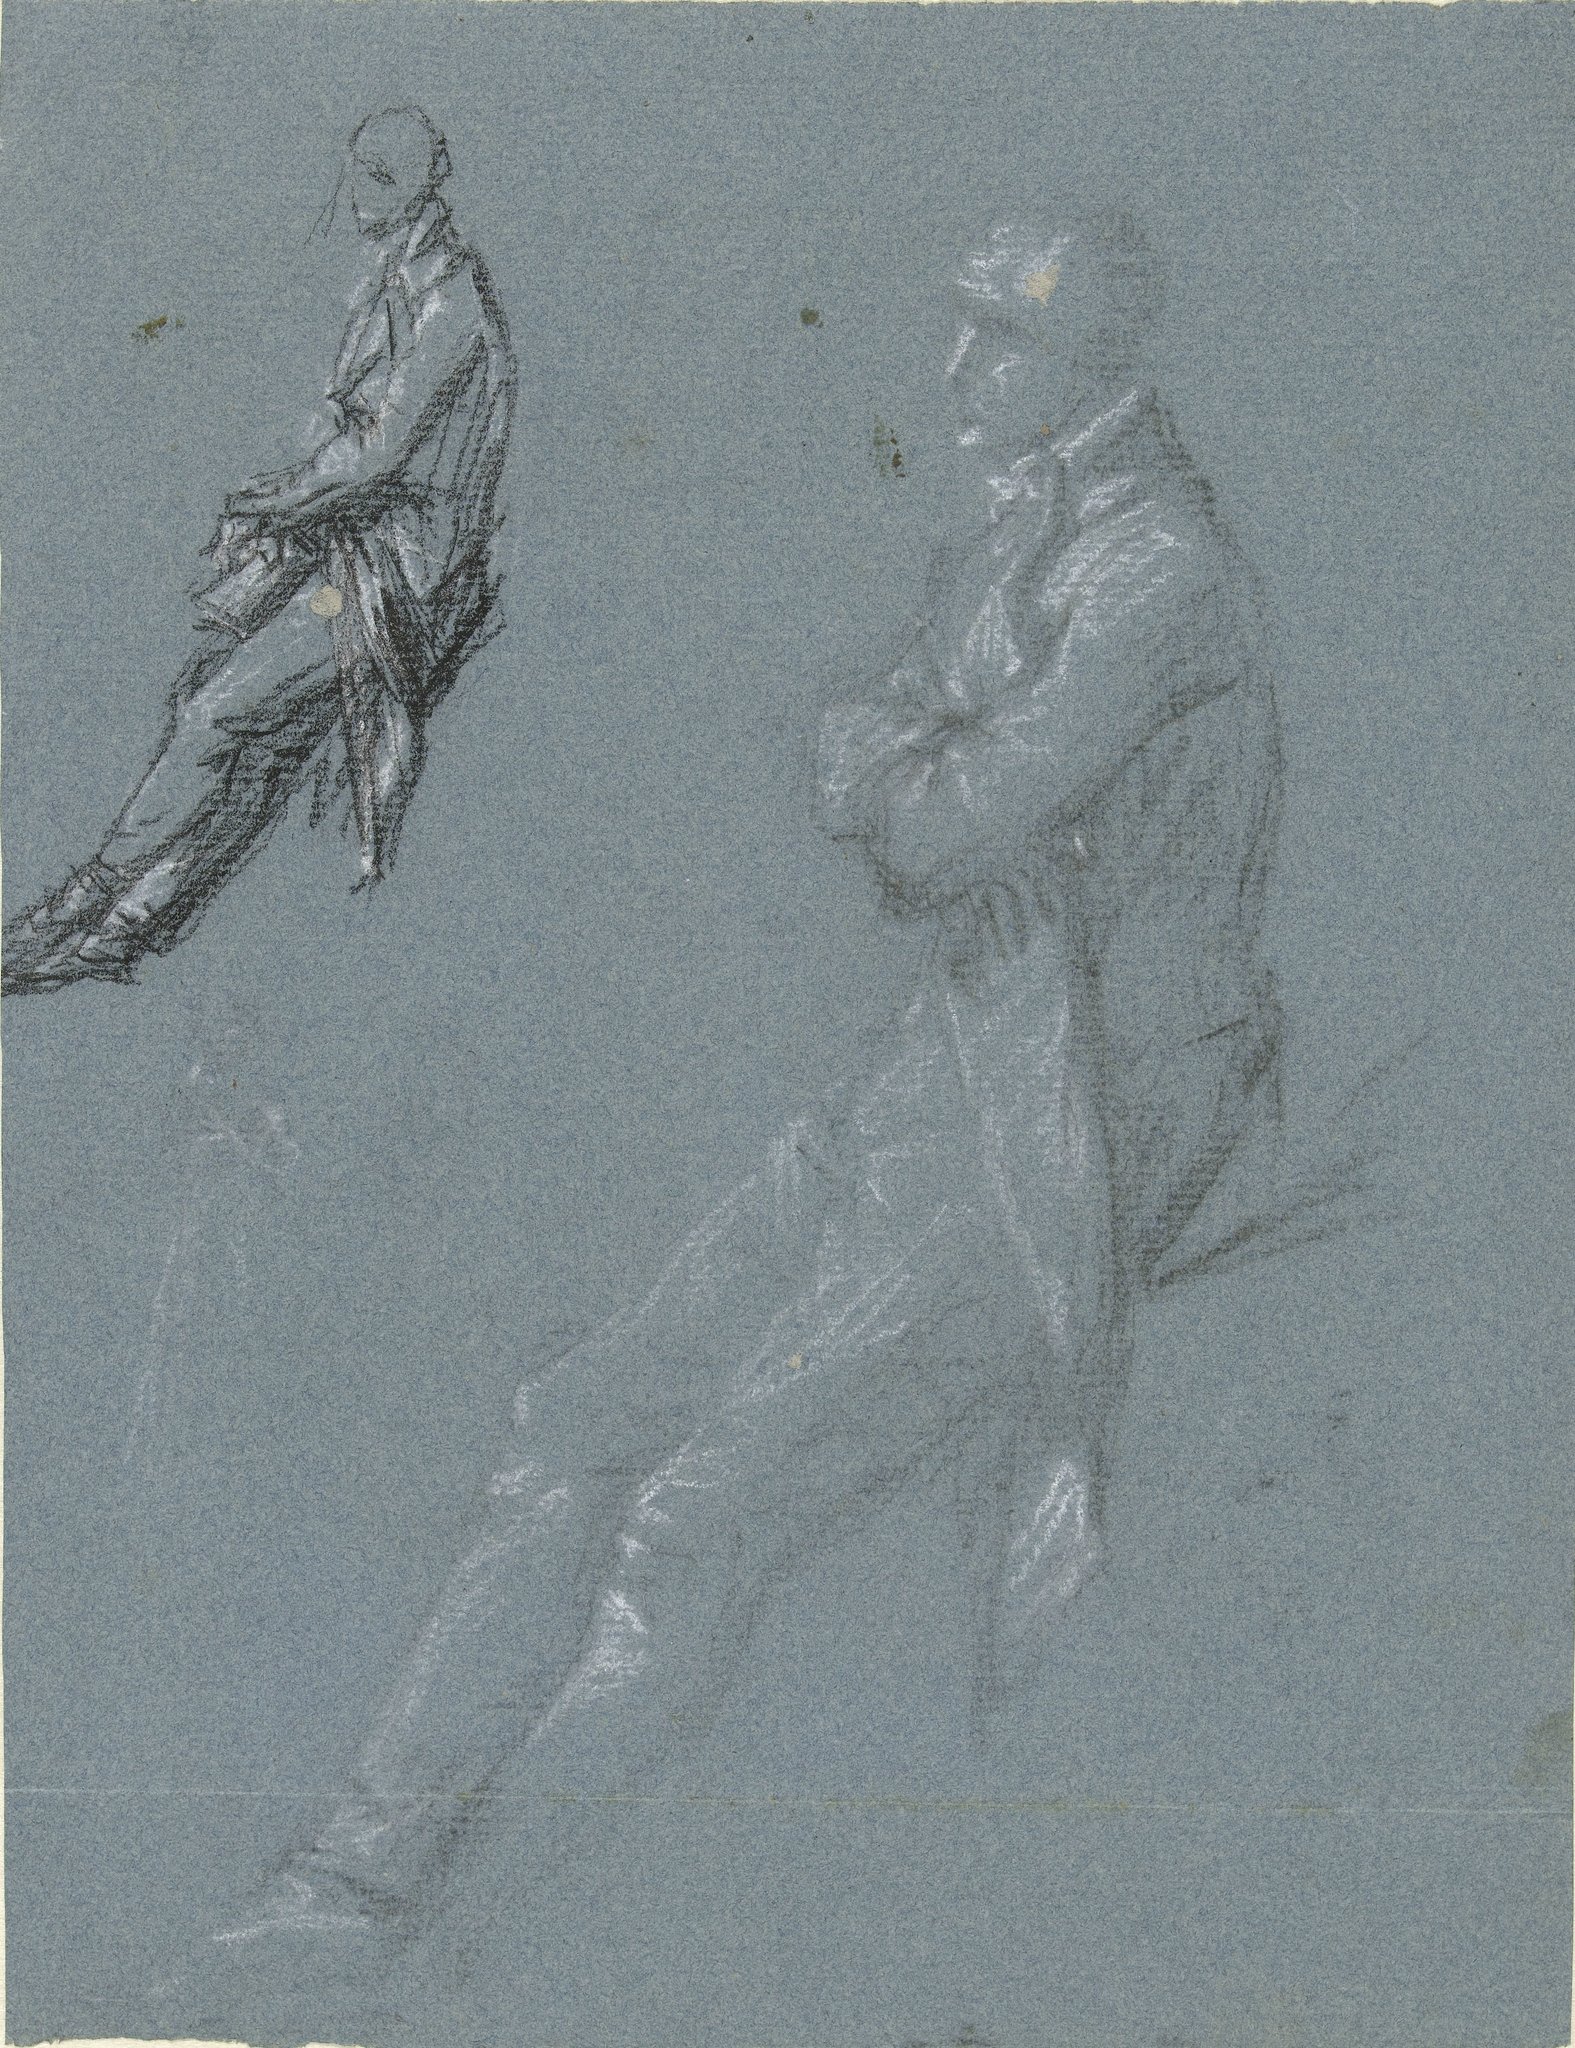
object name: drawing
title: Twee studies van Rutger Jan Schimmelpenninck en een schets van zijn vrouw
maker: pierre prudhon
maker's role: draughtsman, painter, print maker, publisher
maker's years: 1758-1823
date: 1798-1801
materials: chalk, paper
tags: deventer, amsterdam, rutger jan schimmelpenninck (1761-1825)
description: Studies voor de figuur van Rutger Jan Schimmelpenninck (1761-1825) op het portret van hem en zijn gezin in het Rijksmuseum (SK-A-3097); tevens een zeer lichte schets voor de staande figuur van zijn vrouw.